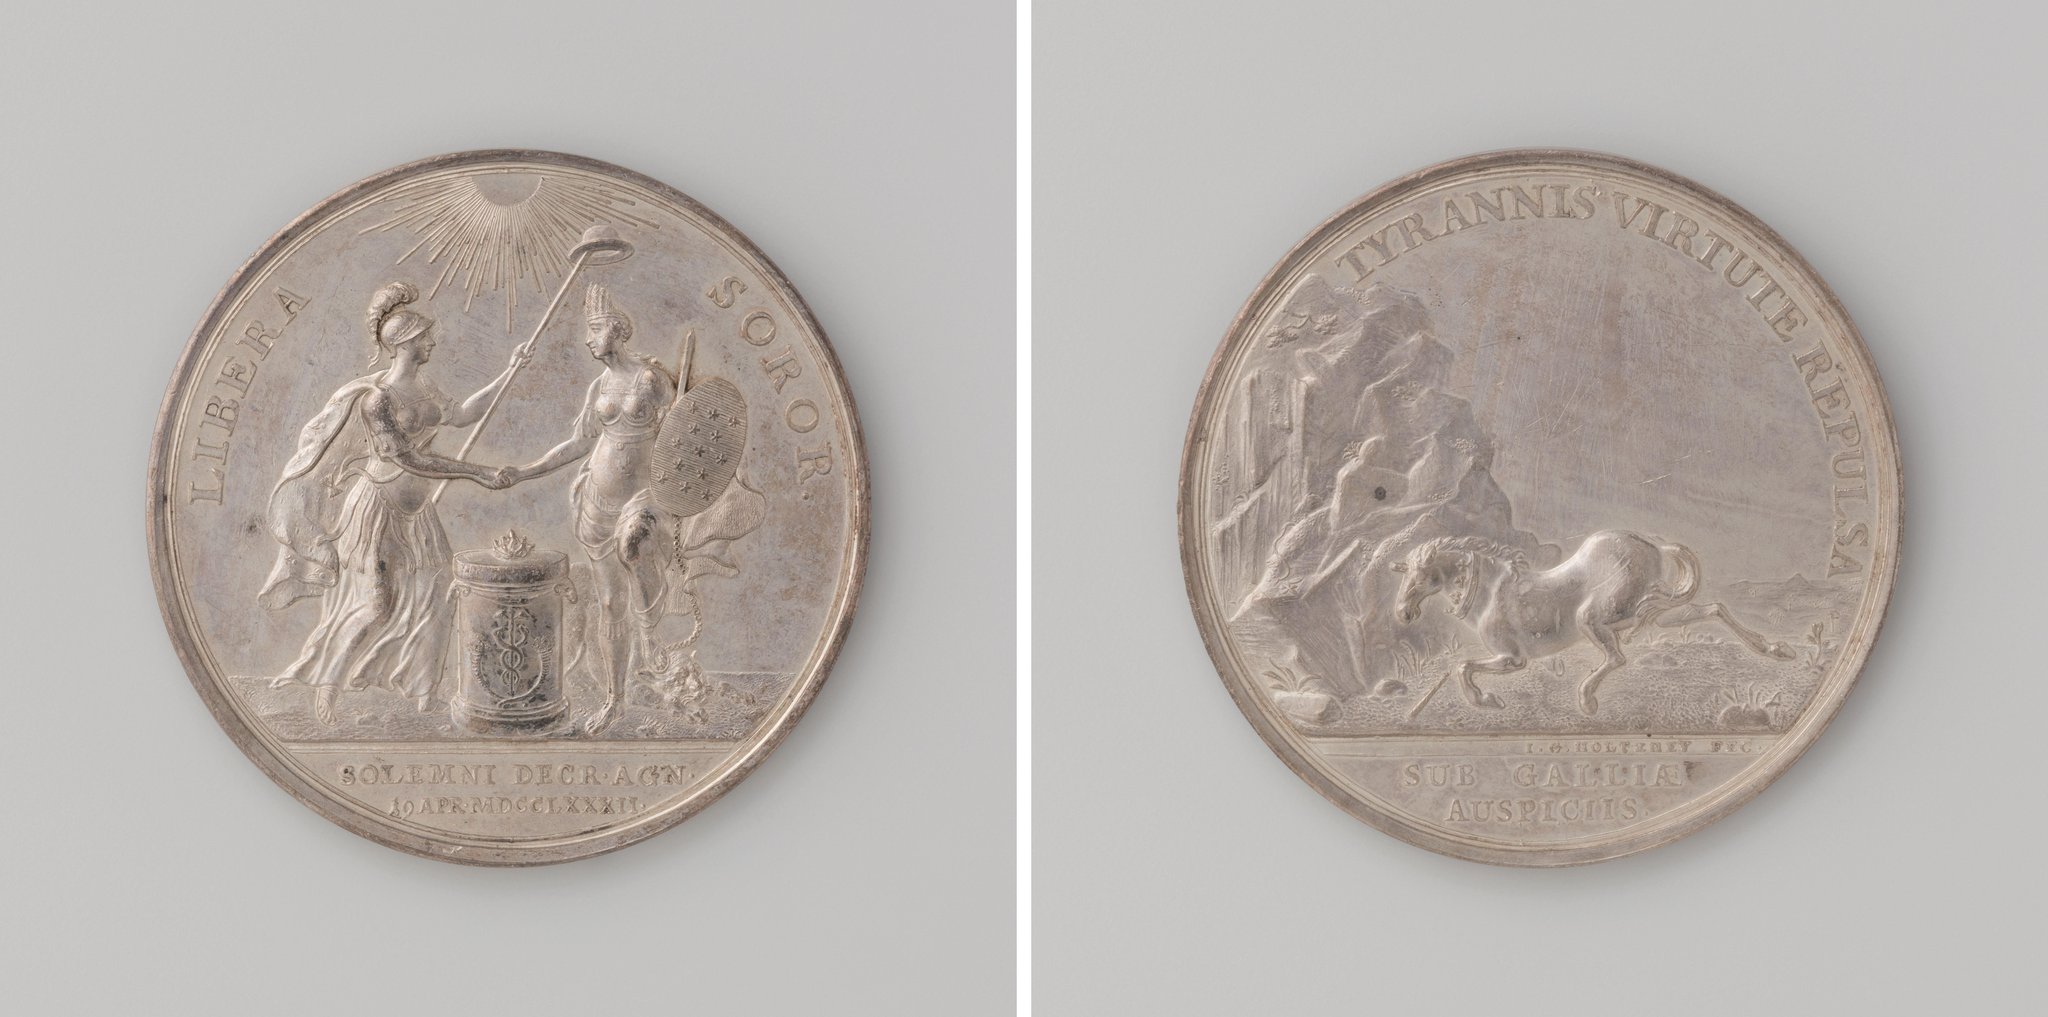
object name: history medal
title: Erkenning van de onafhankelijkheid van de Verenigde Staten van Amerika door de Staten-Generaal der Verenigde Nederlanden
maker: johan george holtzhey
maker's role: mintmaster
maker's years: 1726-1808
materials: silver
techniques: striking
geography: amsterdam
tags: beasts of prey, predatory animals: leopard, unicorn, america represented allegorically; 'america' (ripa), united states of america